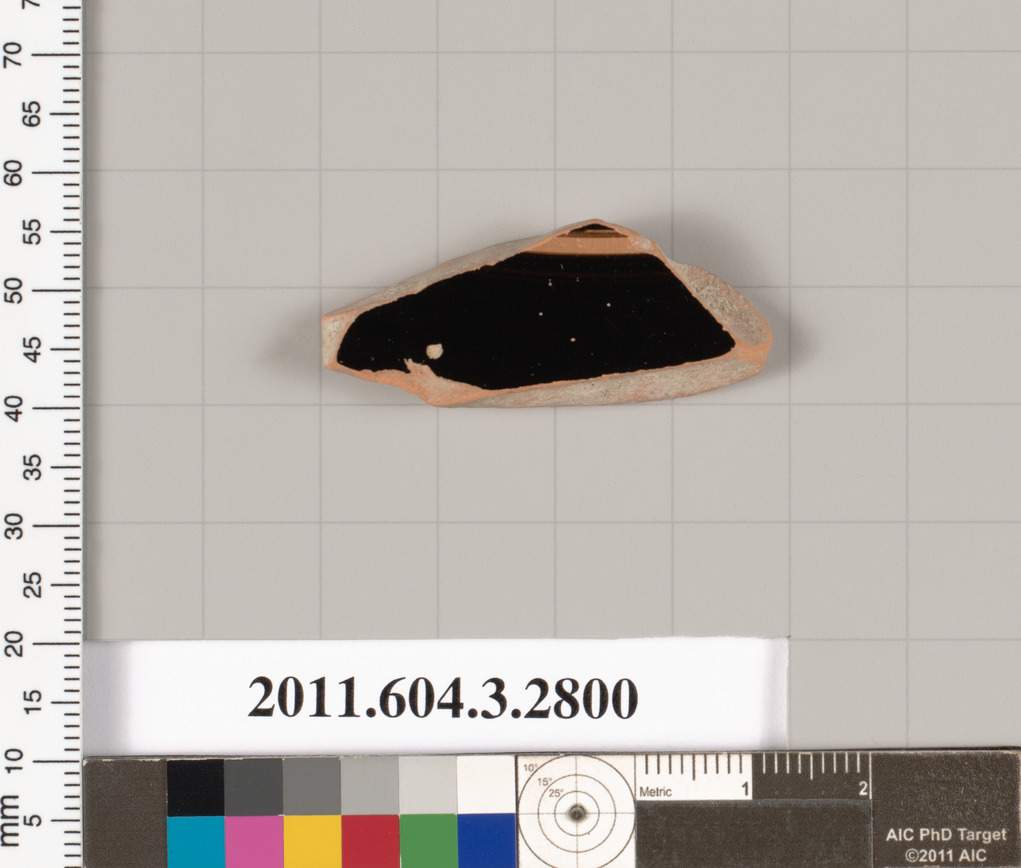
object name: plate fragment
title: Terracotta fragment of a plate?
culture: greek, attic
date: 600-401 BCE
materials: terracotta